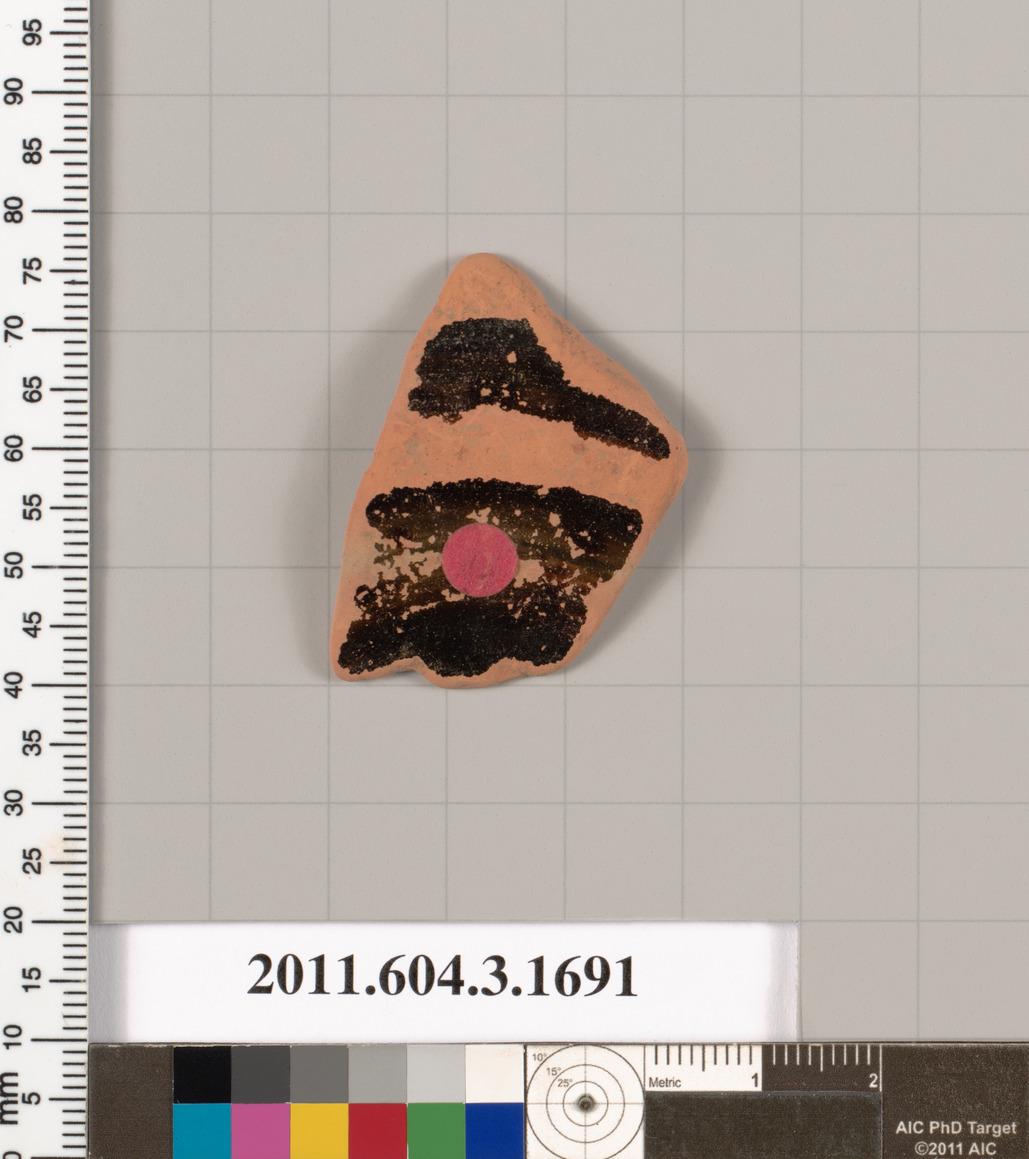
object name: kylix fragment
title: Terracotta fragment of a kylix: Band or lip cup (drinking cup)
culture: greek, attic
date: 550-526 BCE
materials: terracotta